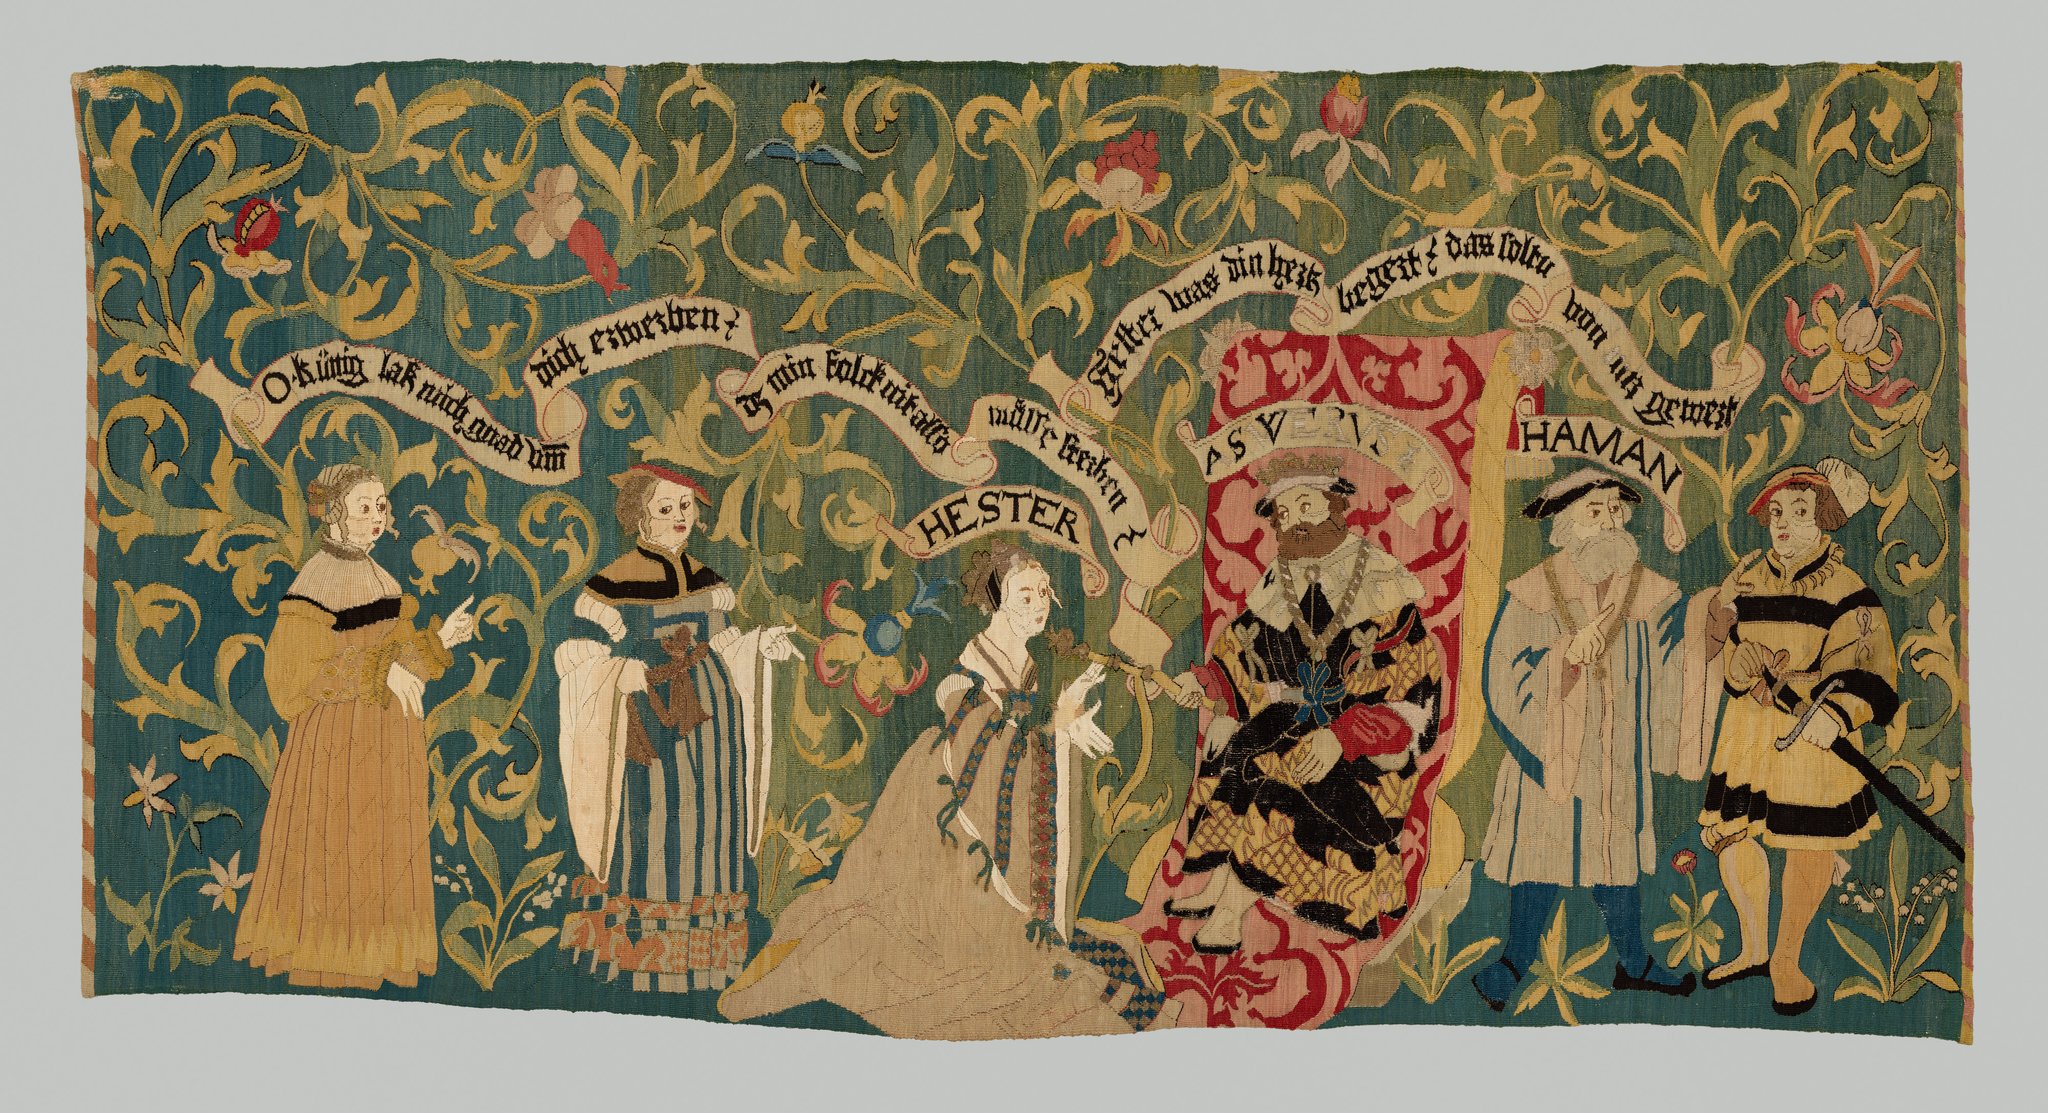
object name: antependium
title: Esther Pleading Before Ahasuerus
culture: upper rhenish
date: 1540-1560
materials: linen, wool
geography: switzerland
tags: men,women,esther,ahasuerus